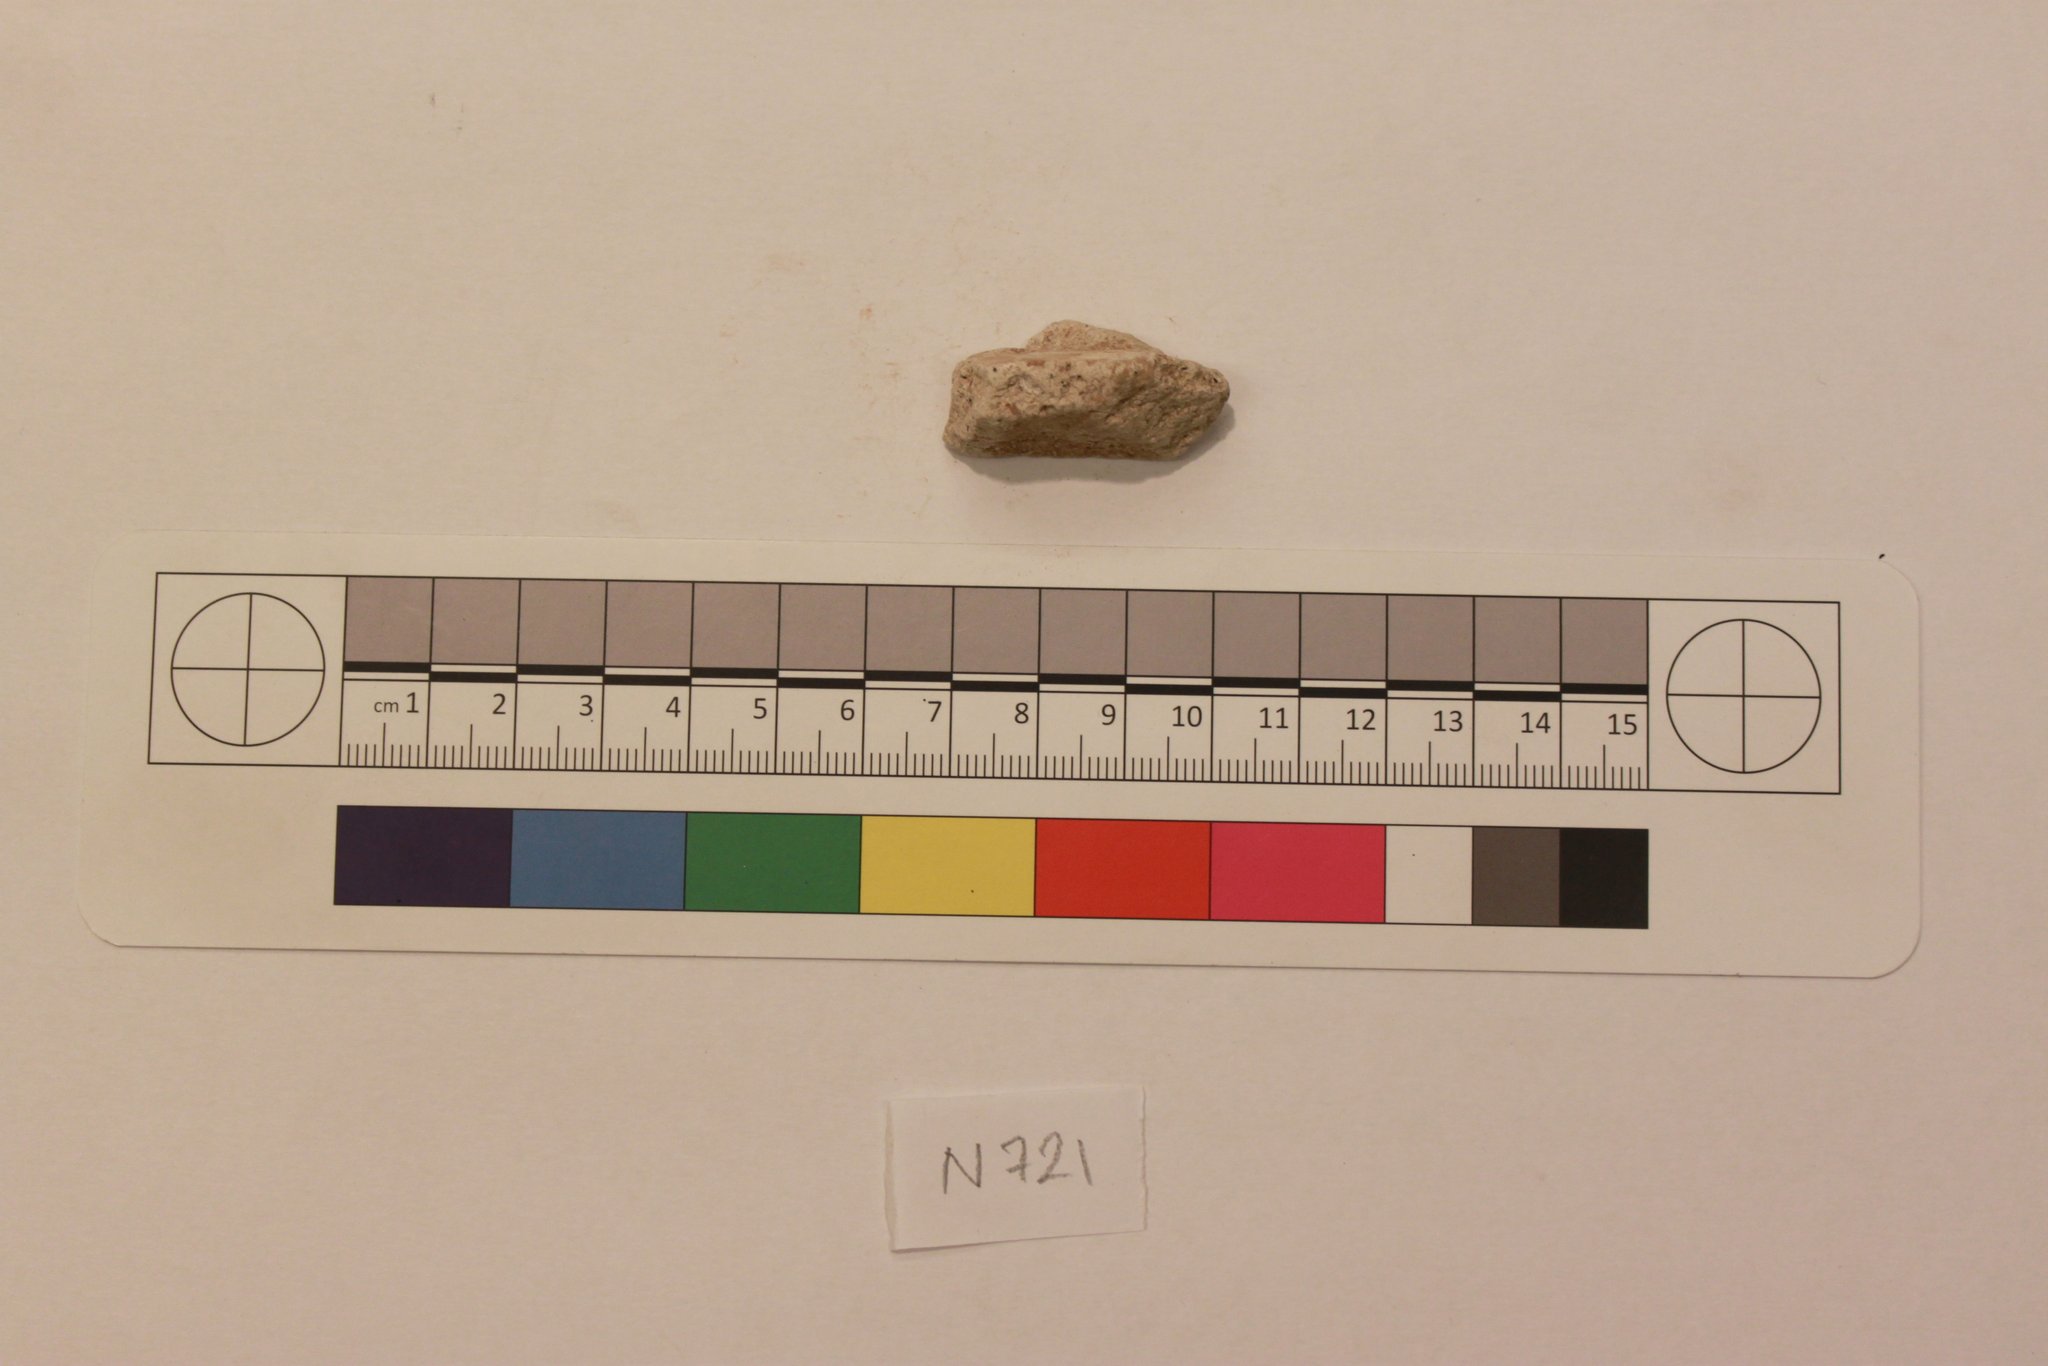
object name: fragment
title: Stucco Fragment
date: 701-1200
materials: plaster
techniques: carving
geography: iran